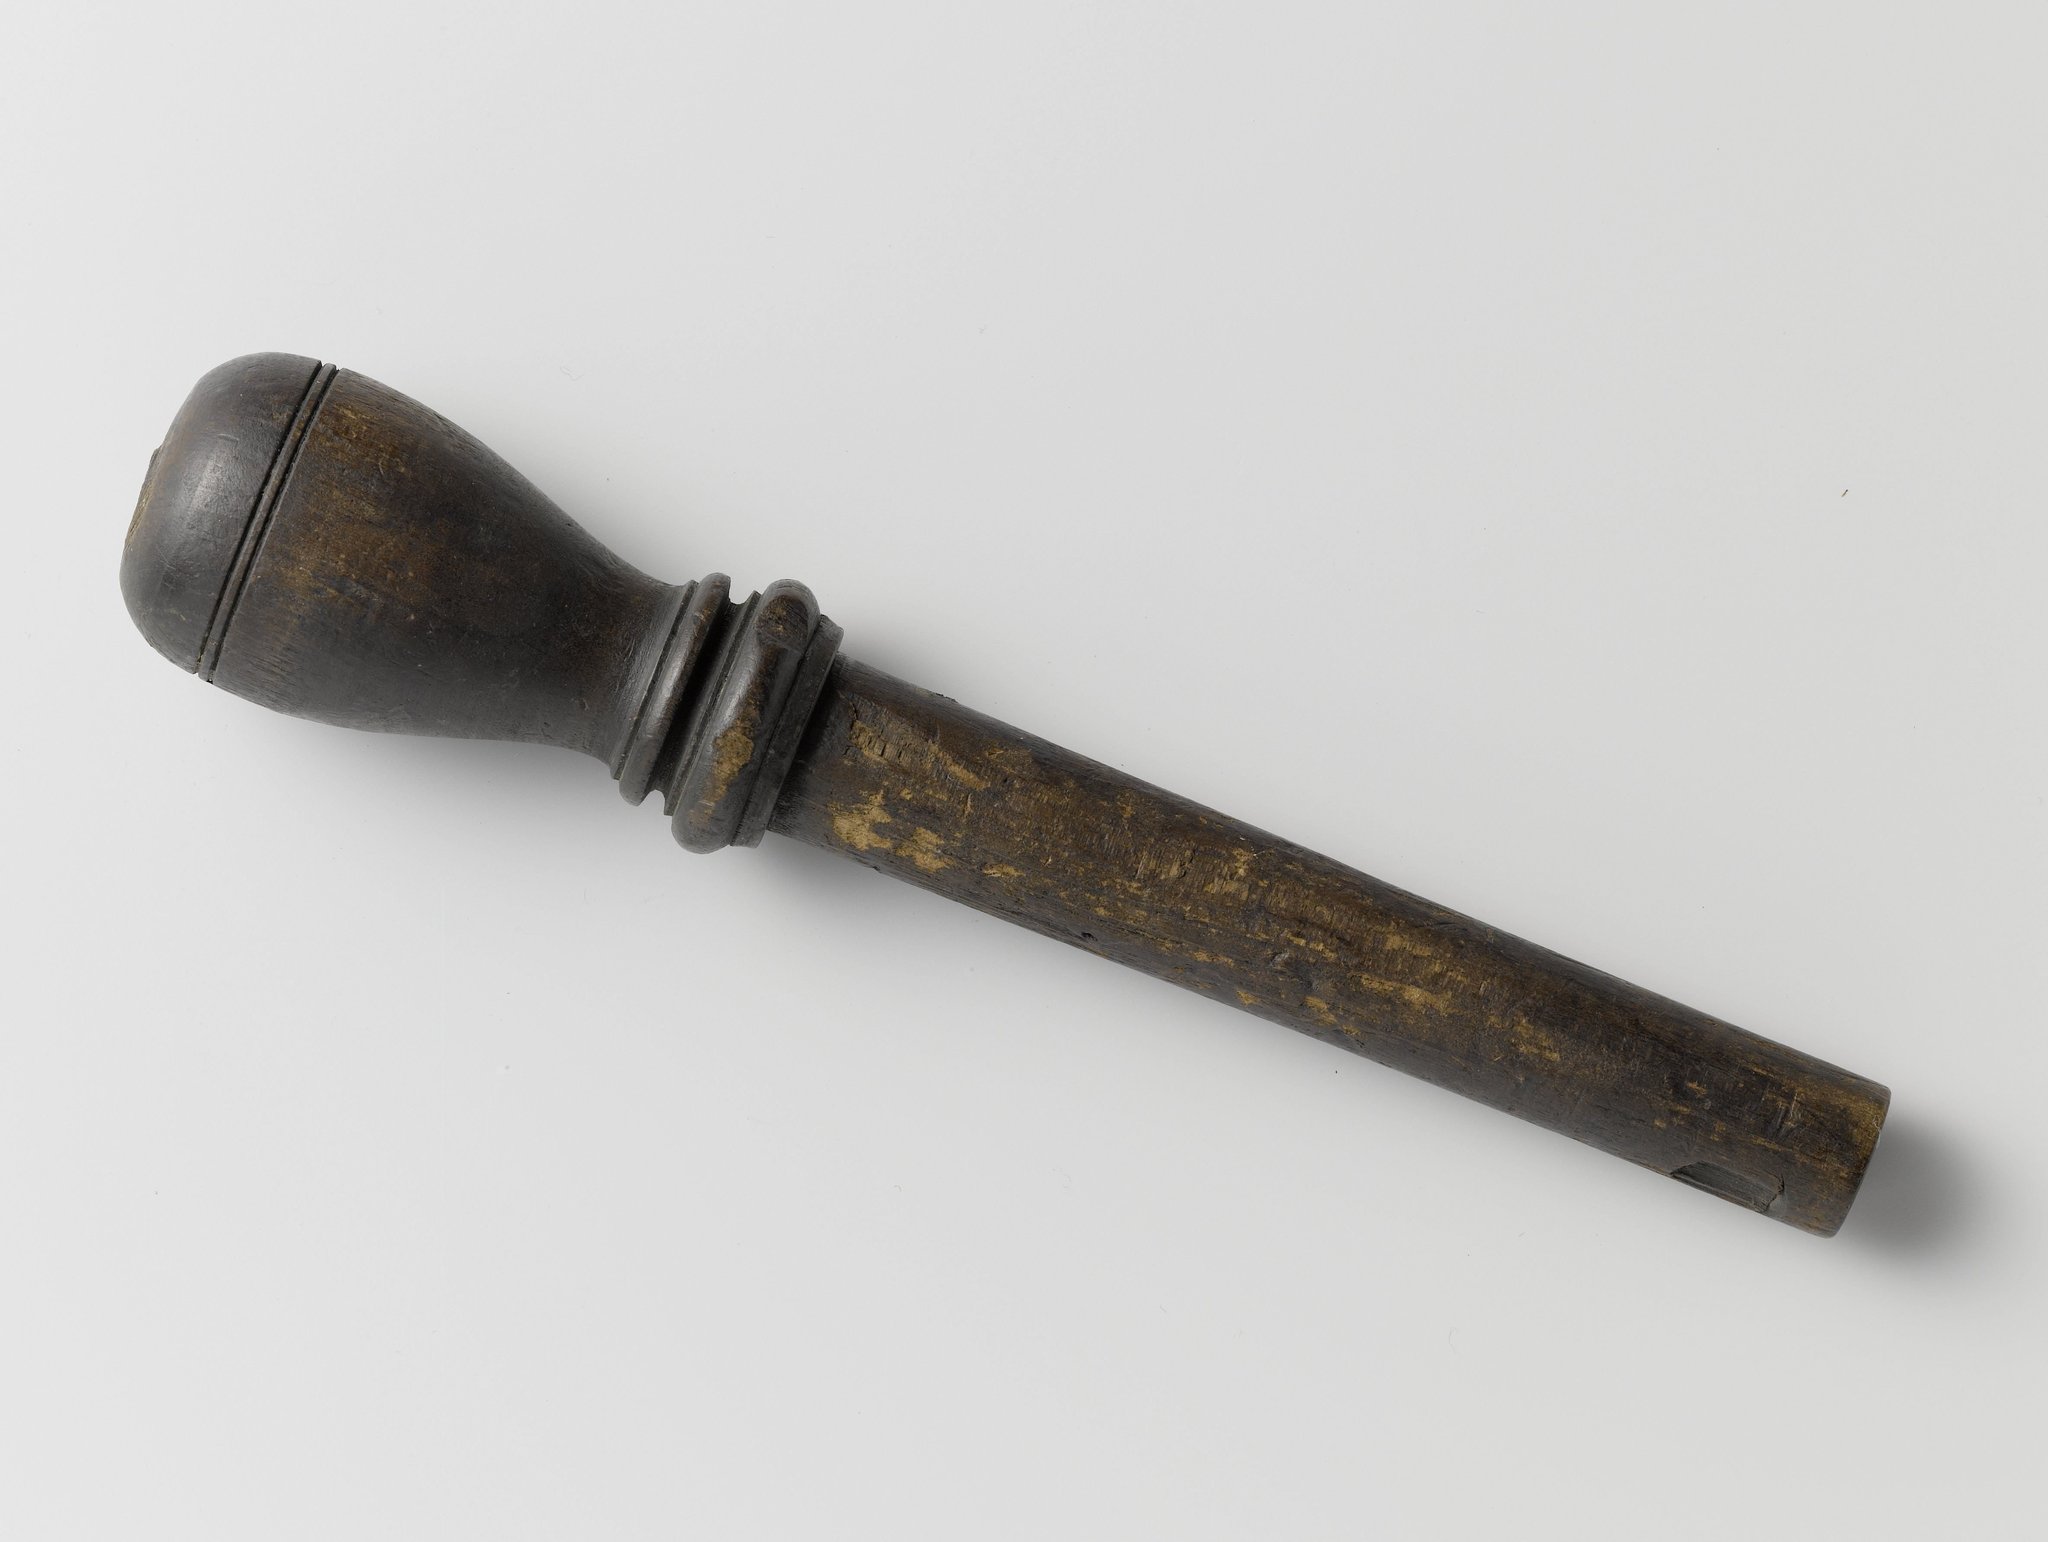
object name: nagel, spijker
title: Nagel met ronde kop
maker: Anonymous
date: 1590-1596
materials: wood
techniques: turning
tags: willem barendsz., amsterdam, jacob van heemskerck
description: Scheepsonderdeel, houten pin met ronde knop, gelijk aan NM-7722-1. Op de nagelbank, welke geplaatst was op de railing van het schip en voorzien was van een aantal gaten, konden de korvijnagels gestoken worden; op deze kon het lopend want belegd worden. De korvijnagels konden ook bevestigd zijn op de knecht achter de mast. De middellijn van de korvijnagel was dezelfde als die van de touwen die er aan vastgemaakt werden.